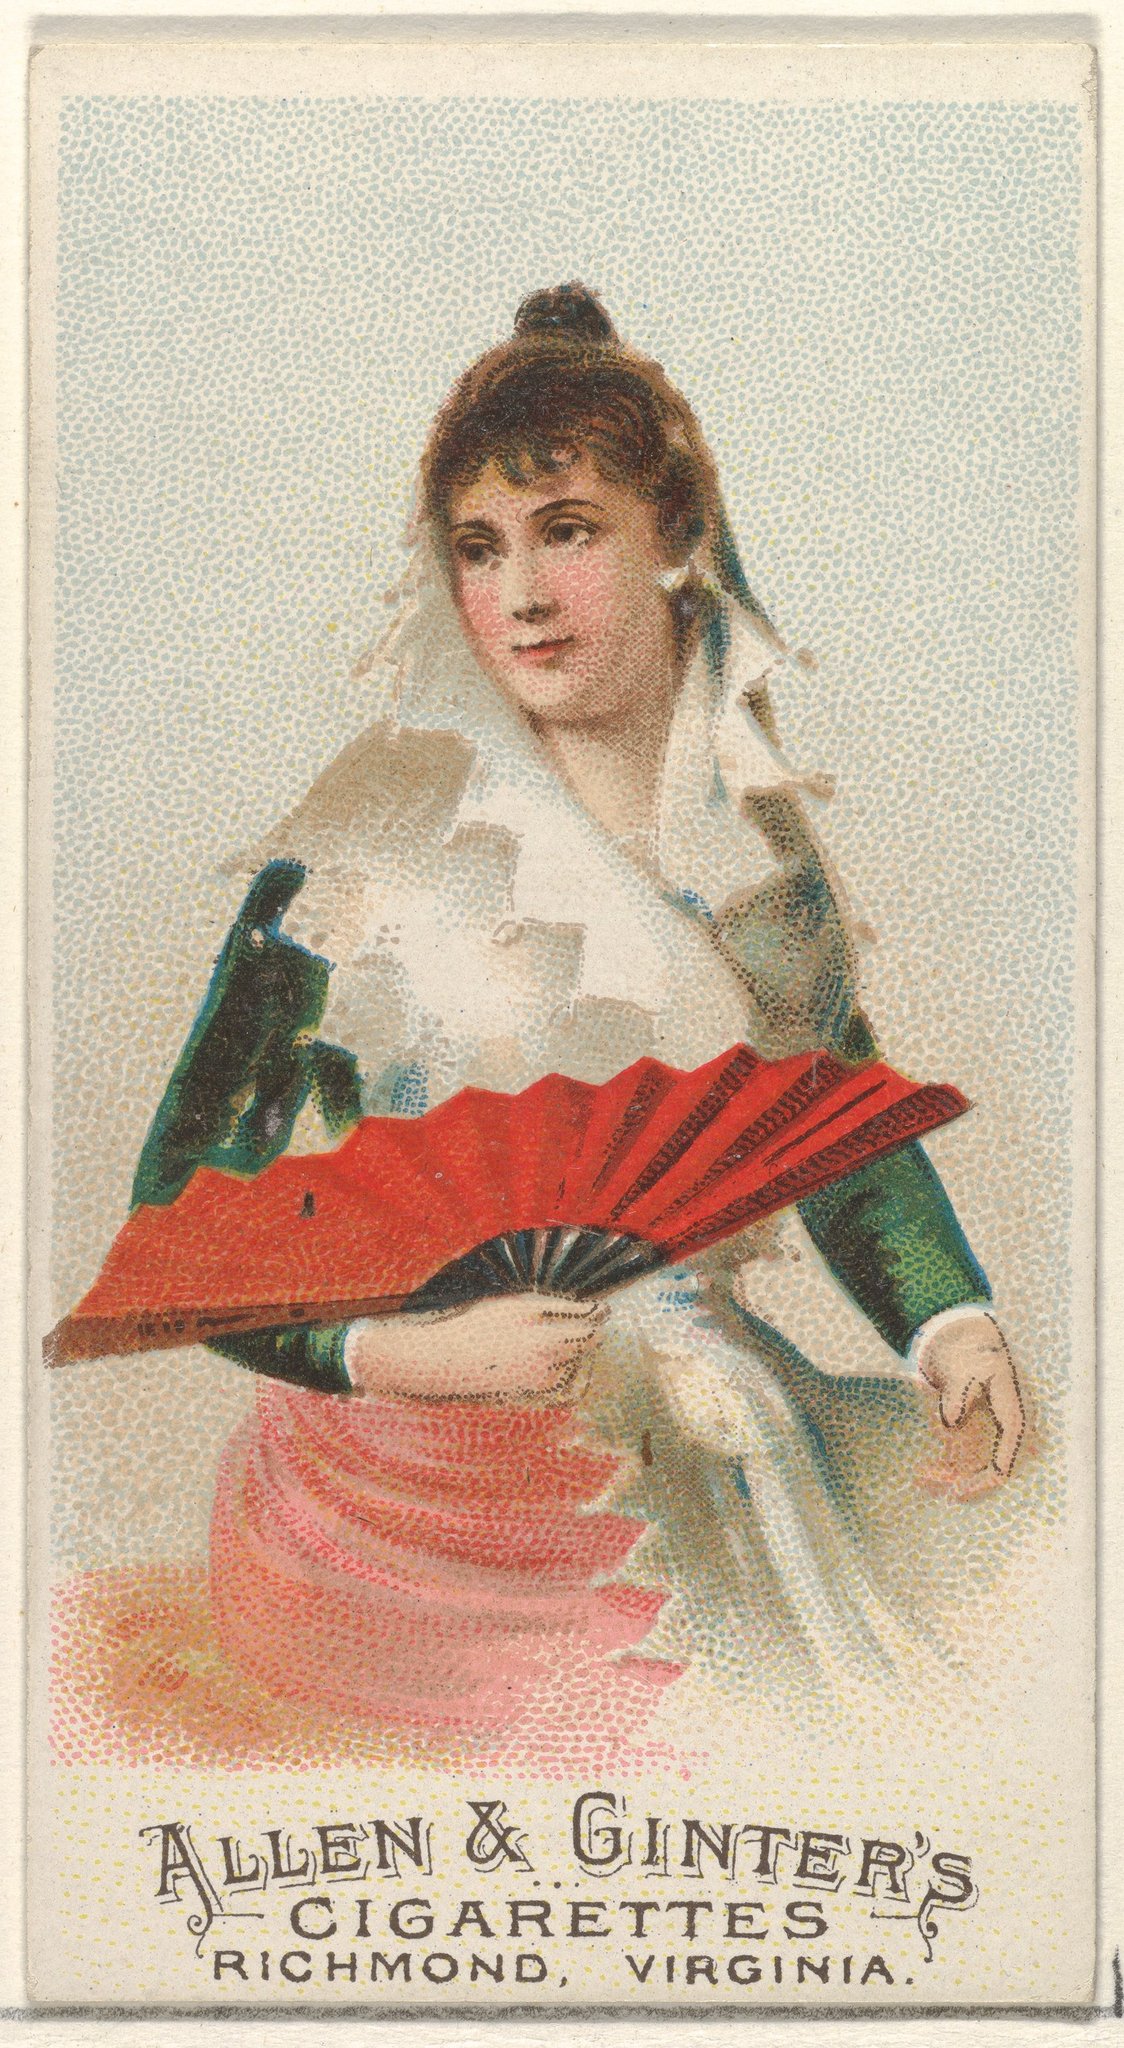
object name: print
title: Plate 45, from the Fans of the Period series (N7) for Allen & Ginter Cigarettes Brands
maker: allen & ginter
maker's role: publisher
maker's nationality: american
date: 1889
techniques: color lithograph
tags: fans,women